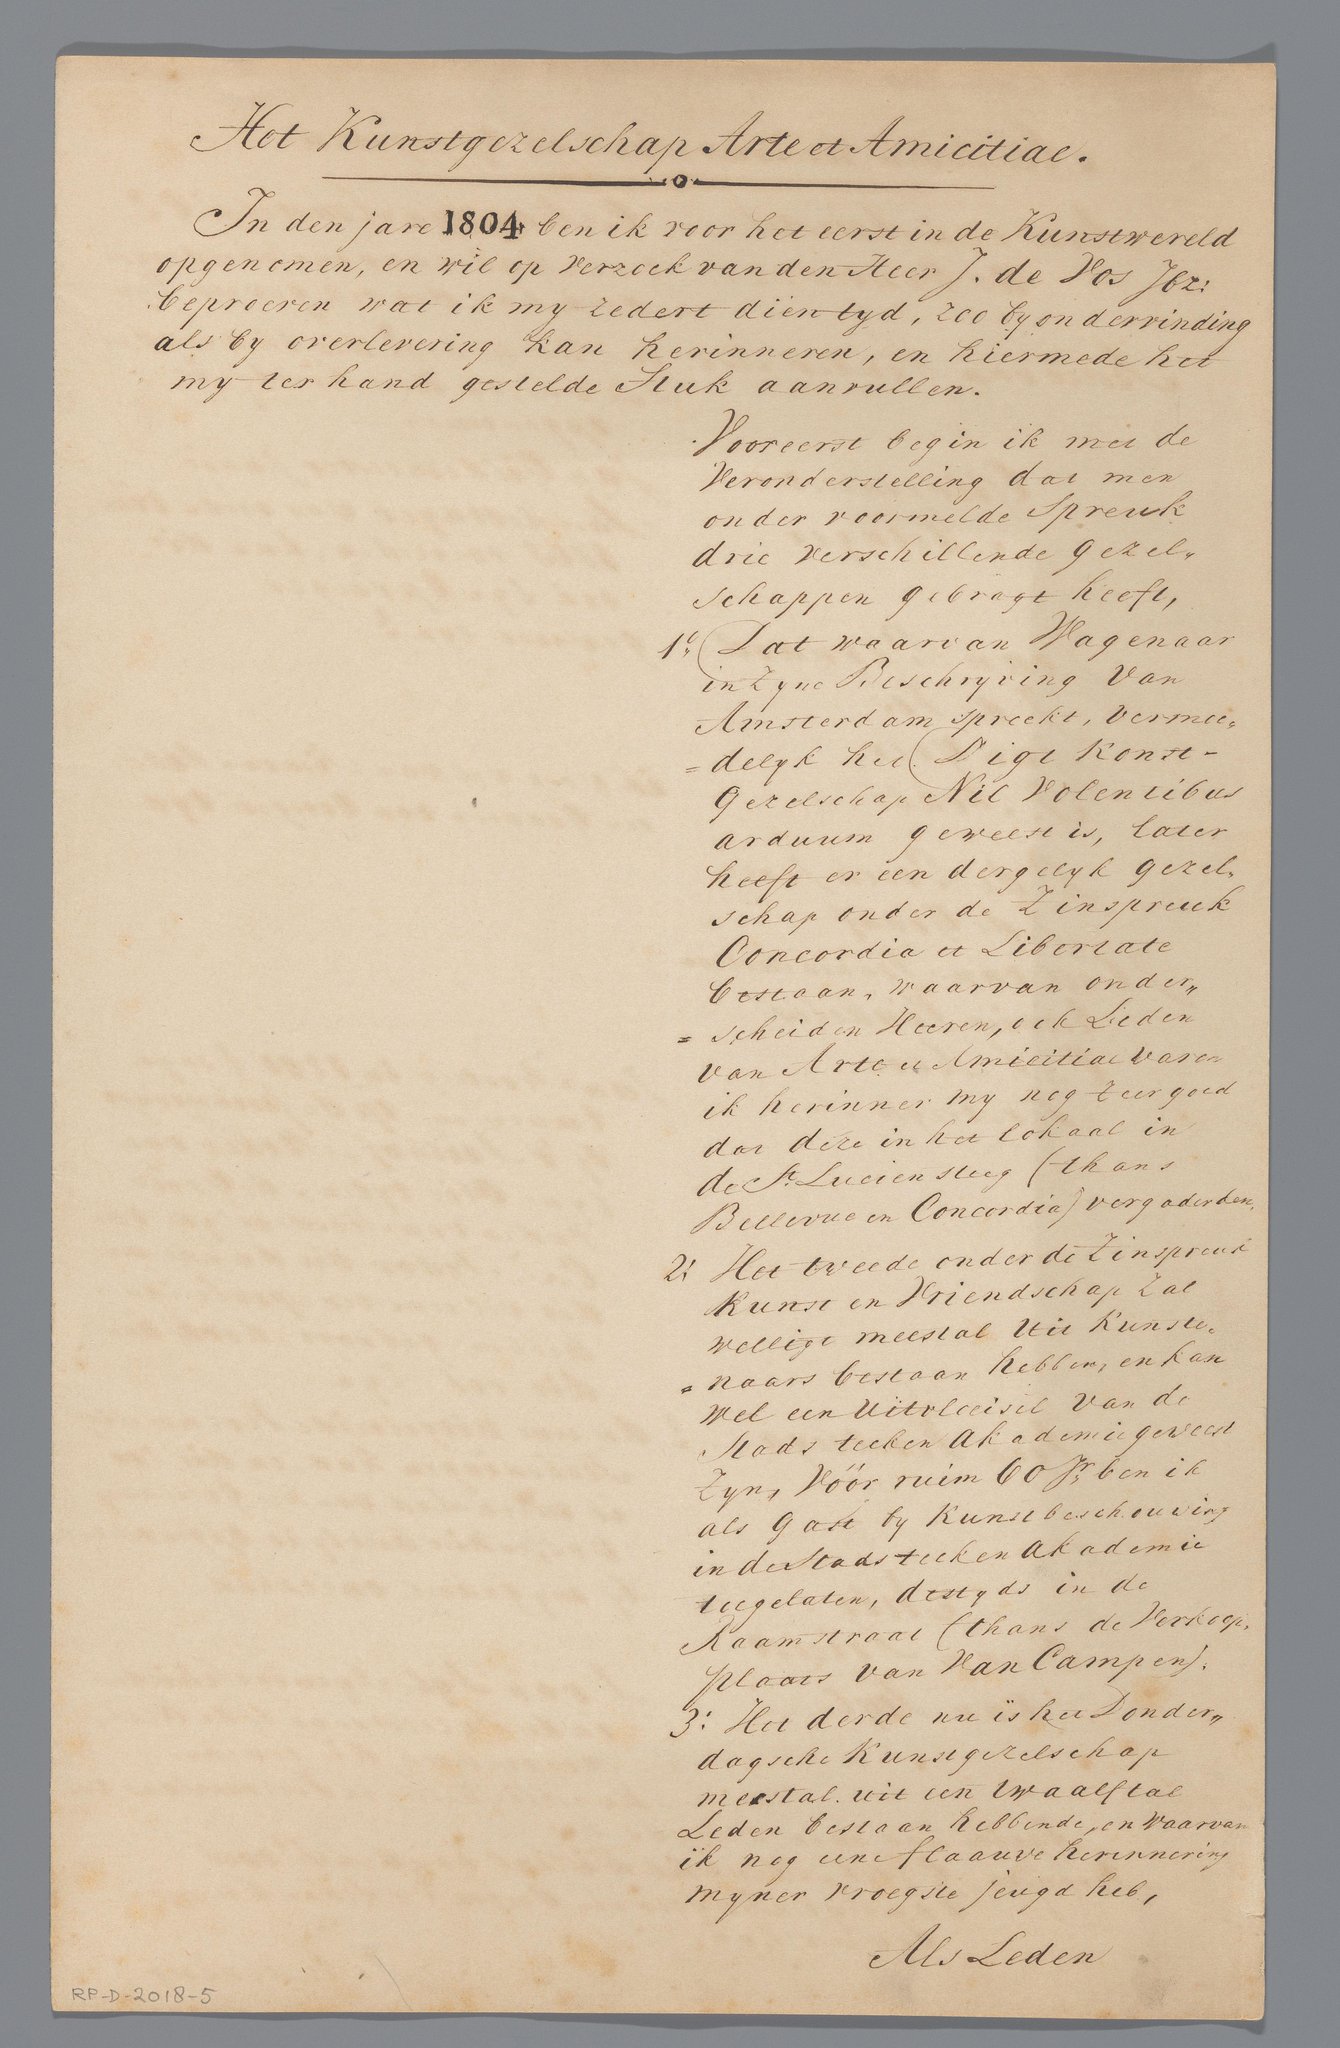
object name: document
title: Aantekeningen over het Kunstgezelschap Arte et Amicitiae, een genootschap van verzamelaars van tekeningen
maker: pieter ernst hendrik praetorius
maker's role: draughtsman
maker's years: 1791-1876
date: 1868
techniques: pen, writing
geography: amsterdam